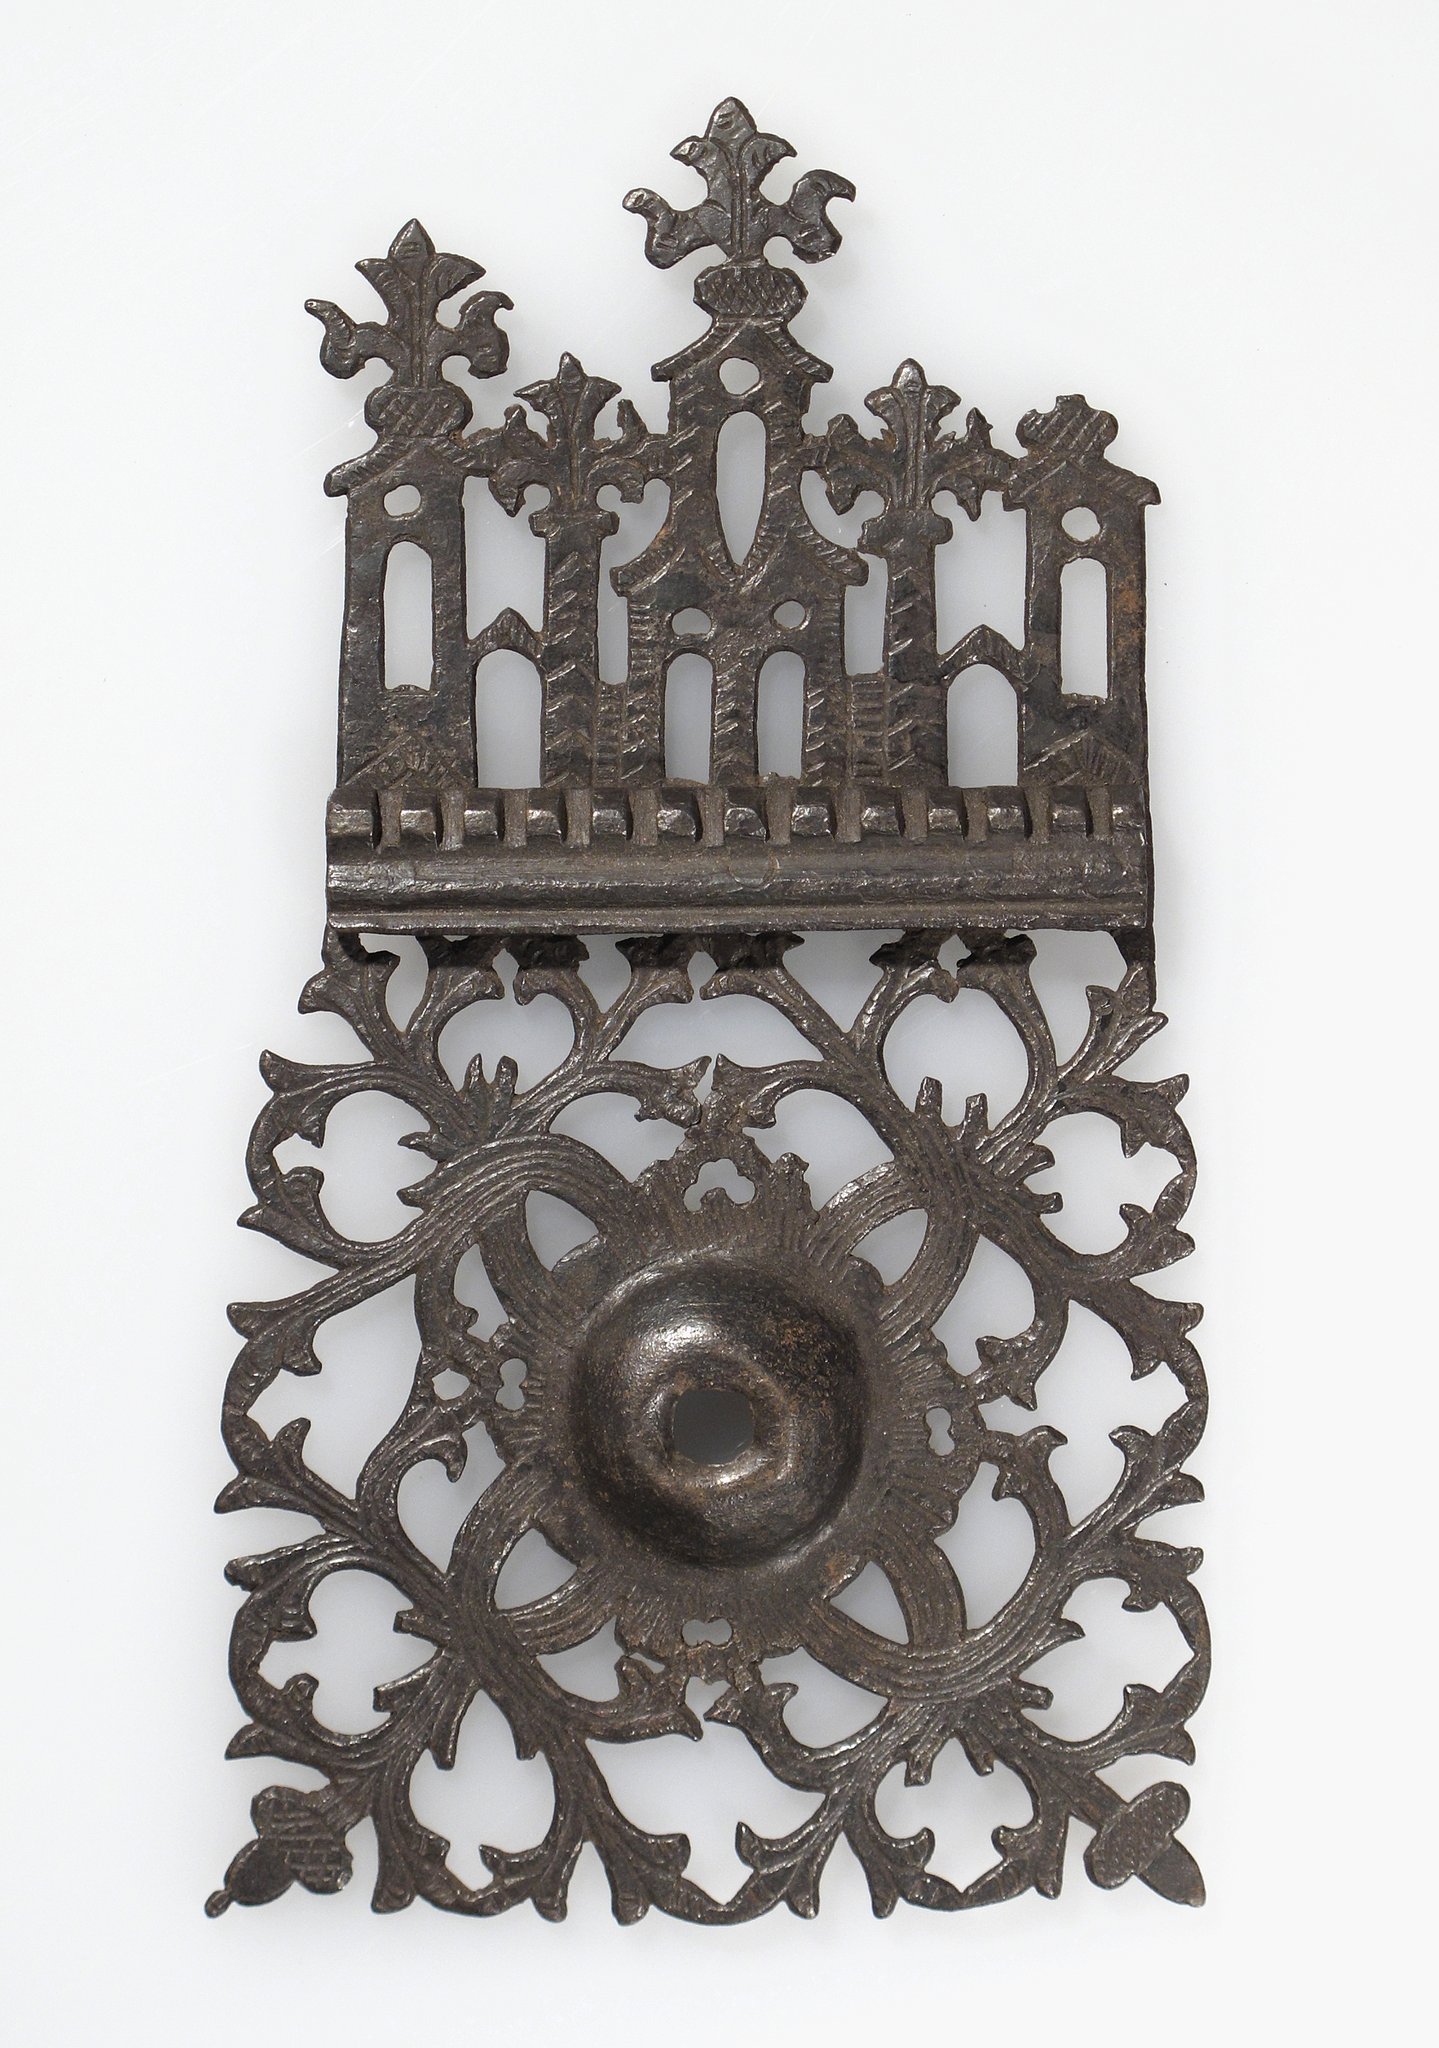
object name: door plate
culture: european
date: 1401-1600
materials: iron